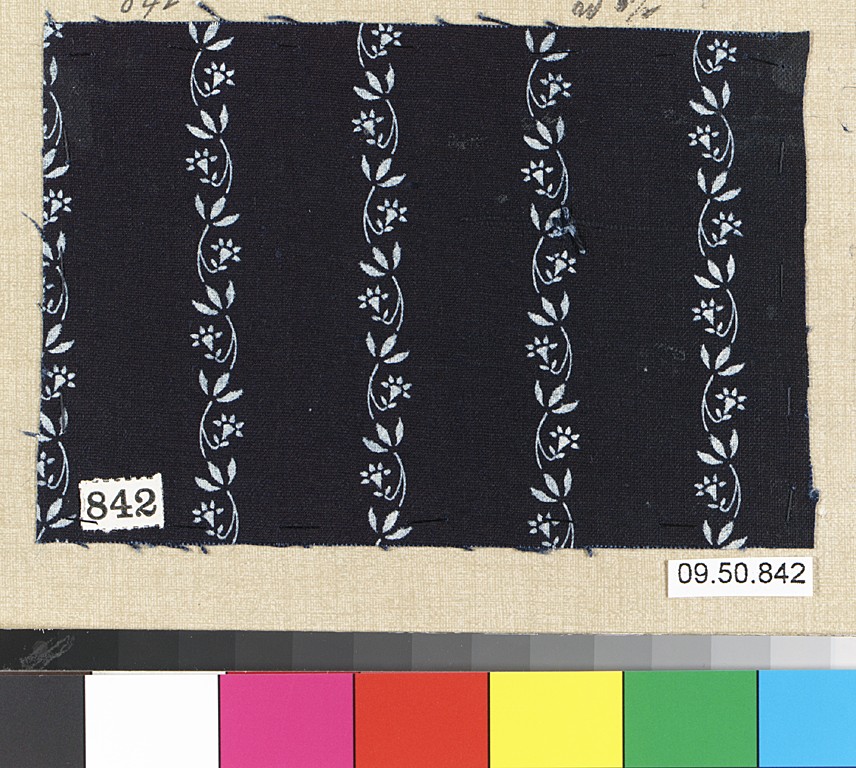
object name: piece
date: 1801-1900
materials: cotton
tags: flowers,leaves